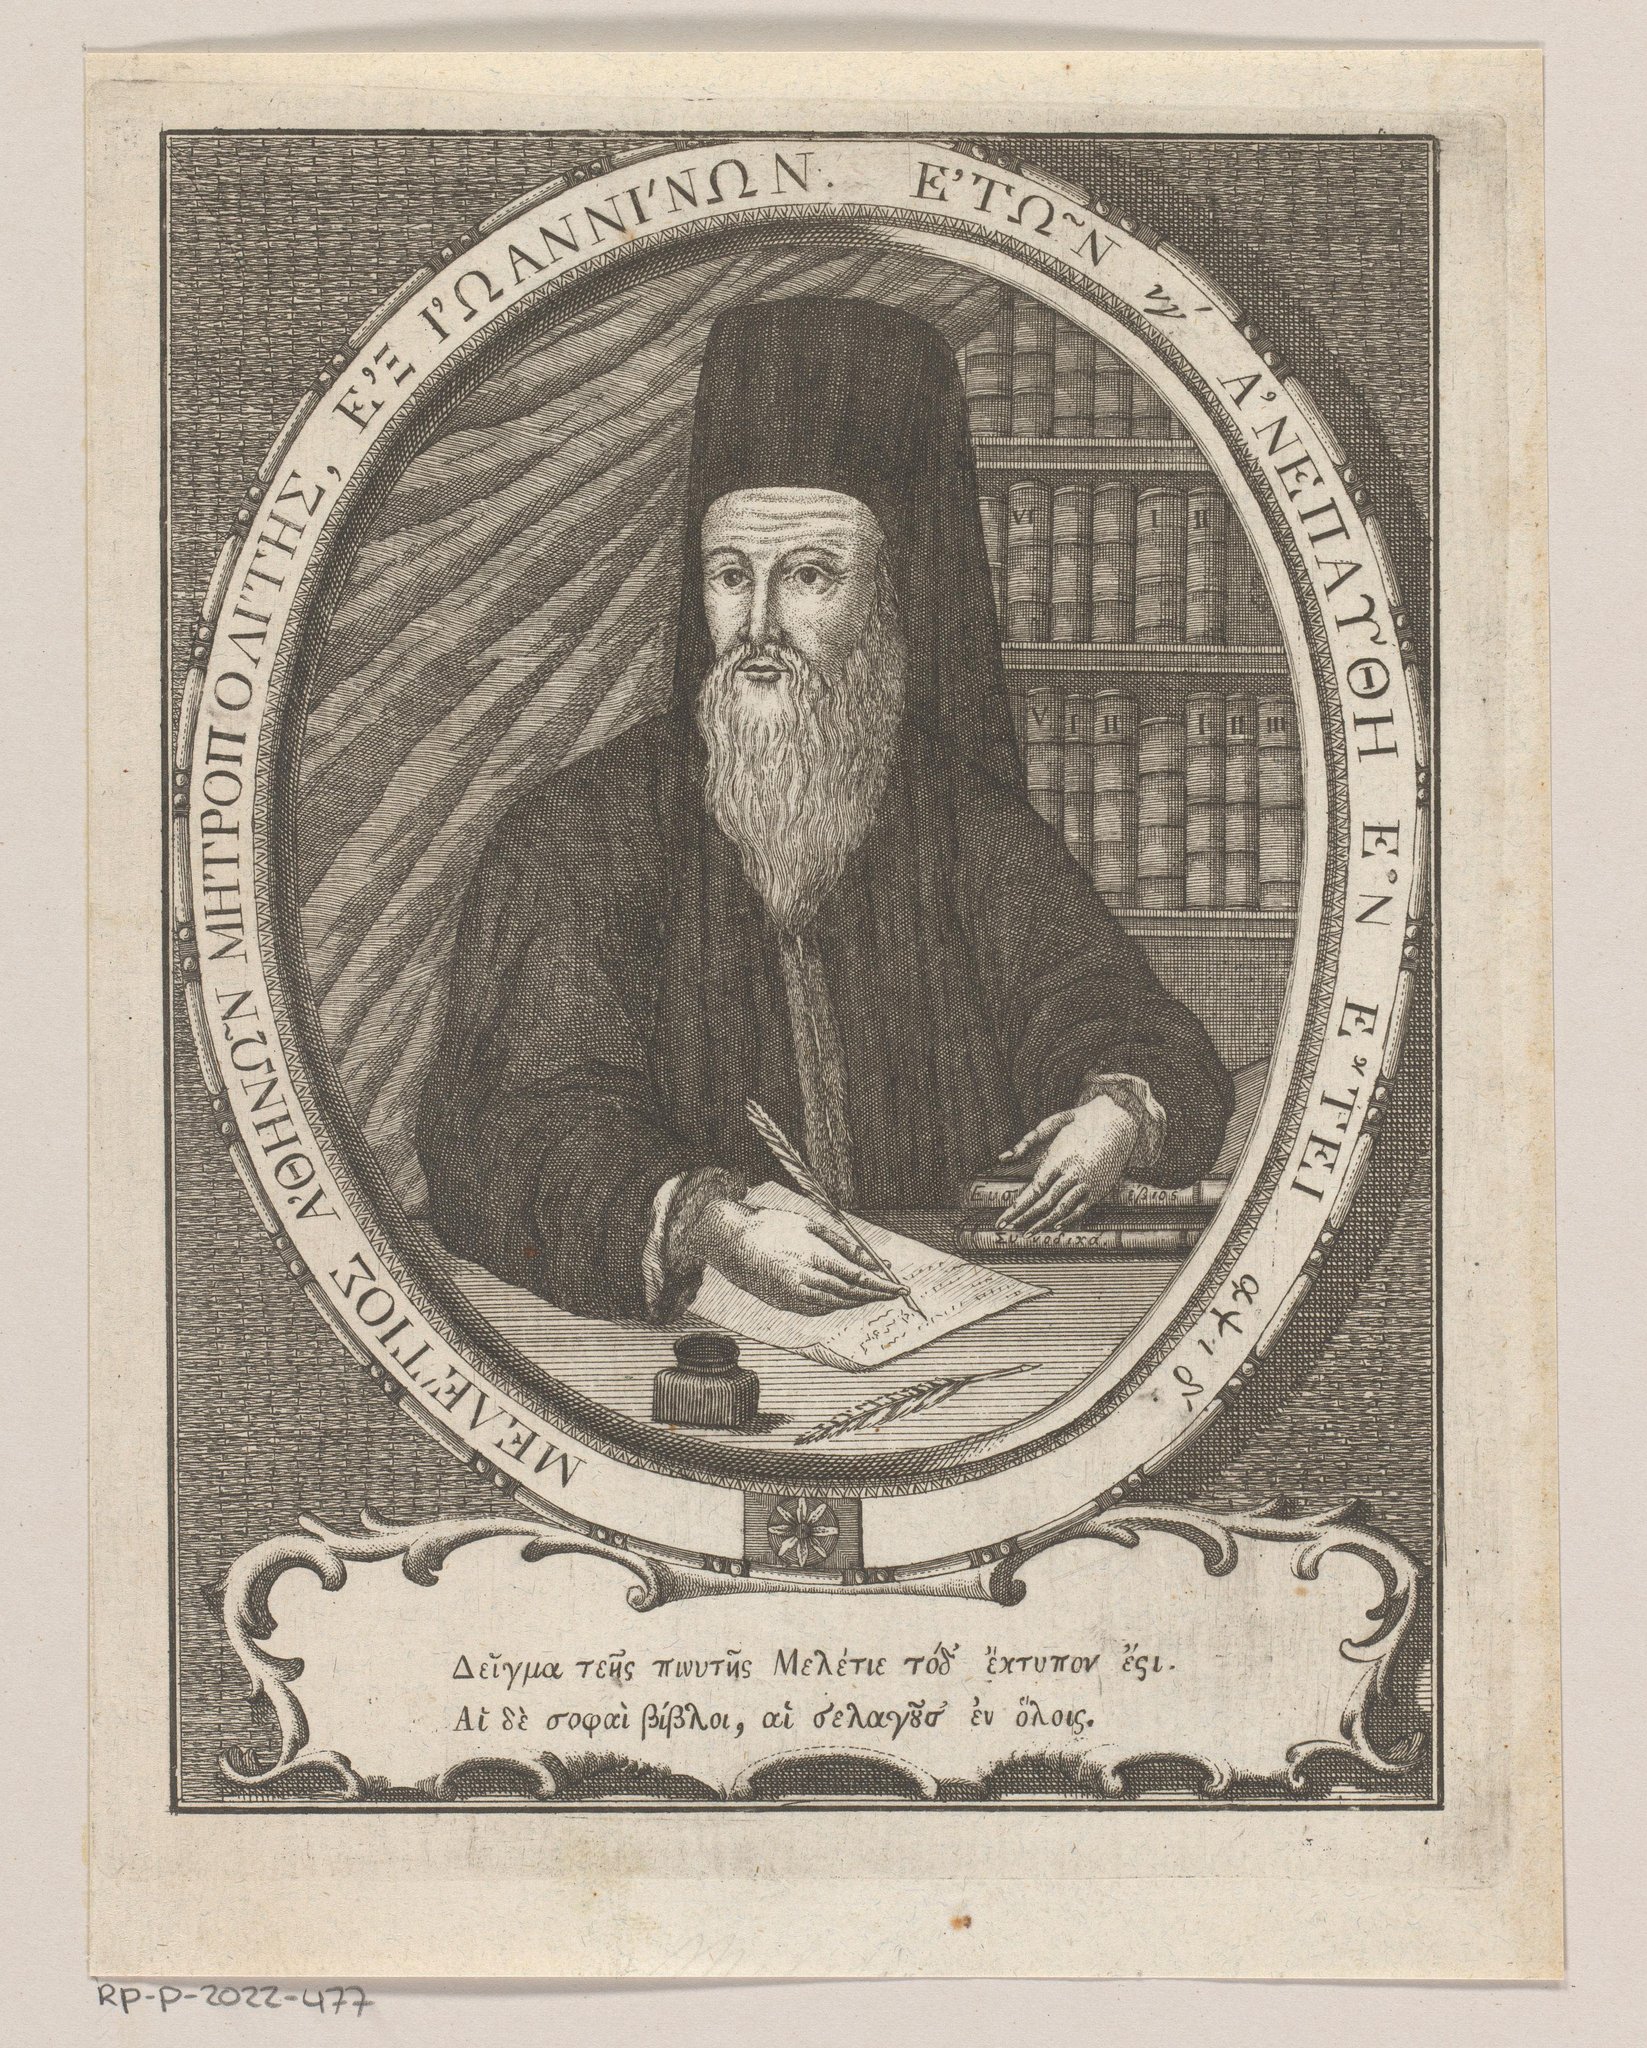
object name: print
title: Portret van Meletius Tapeinos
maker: Anonymous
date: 1633-1750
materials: paper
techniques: etching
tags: historical persons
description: Met tweeregelig onderschrift in het Grieks.